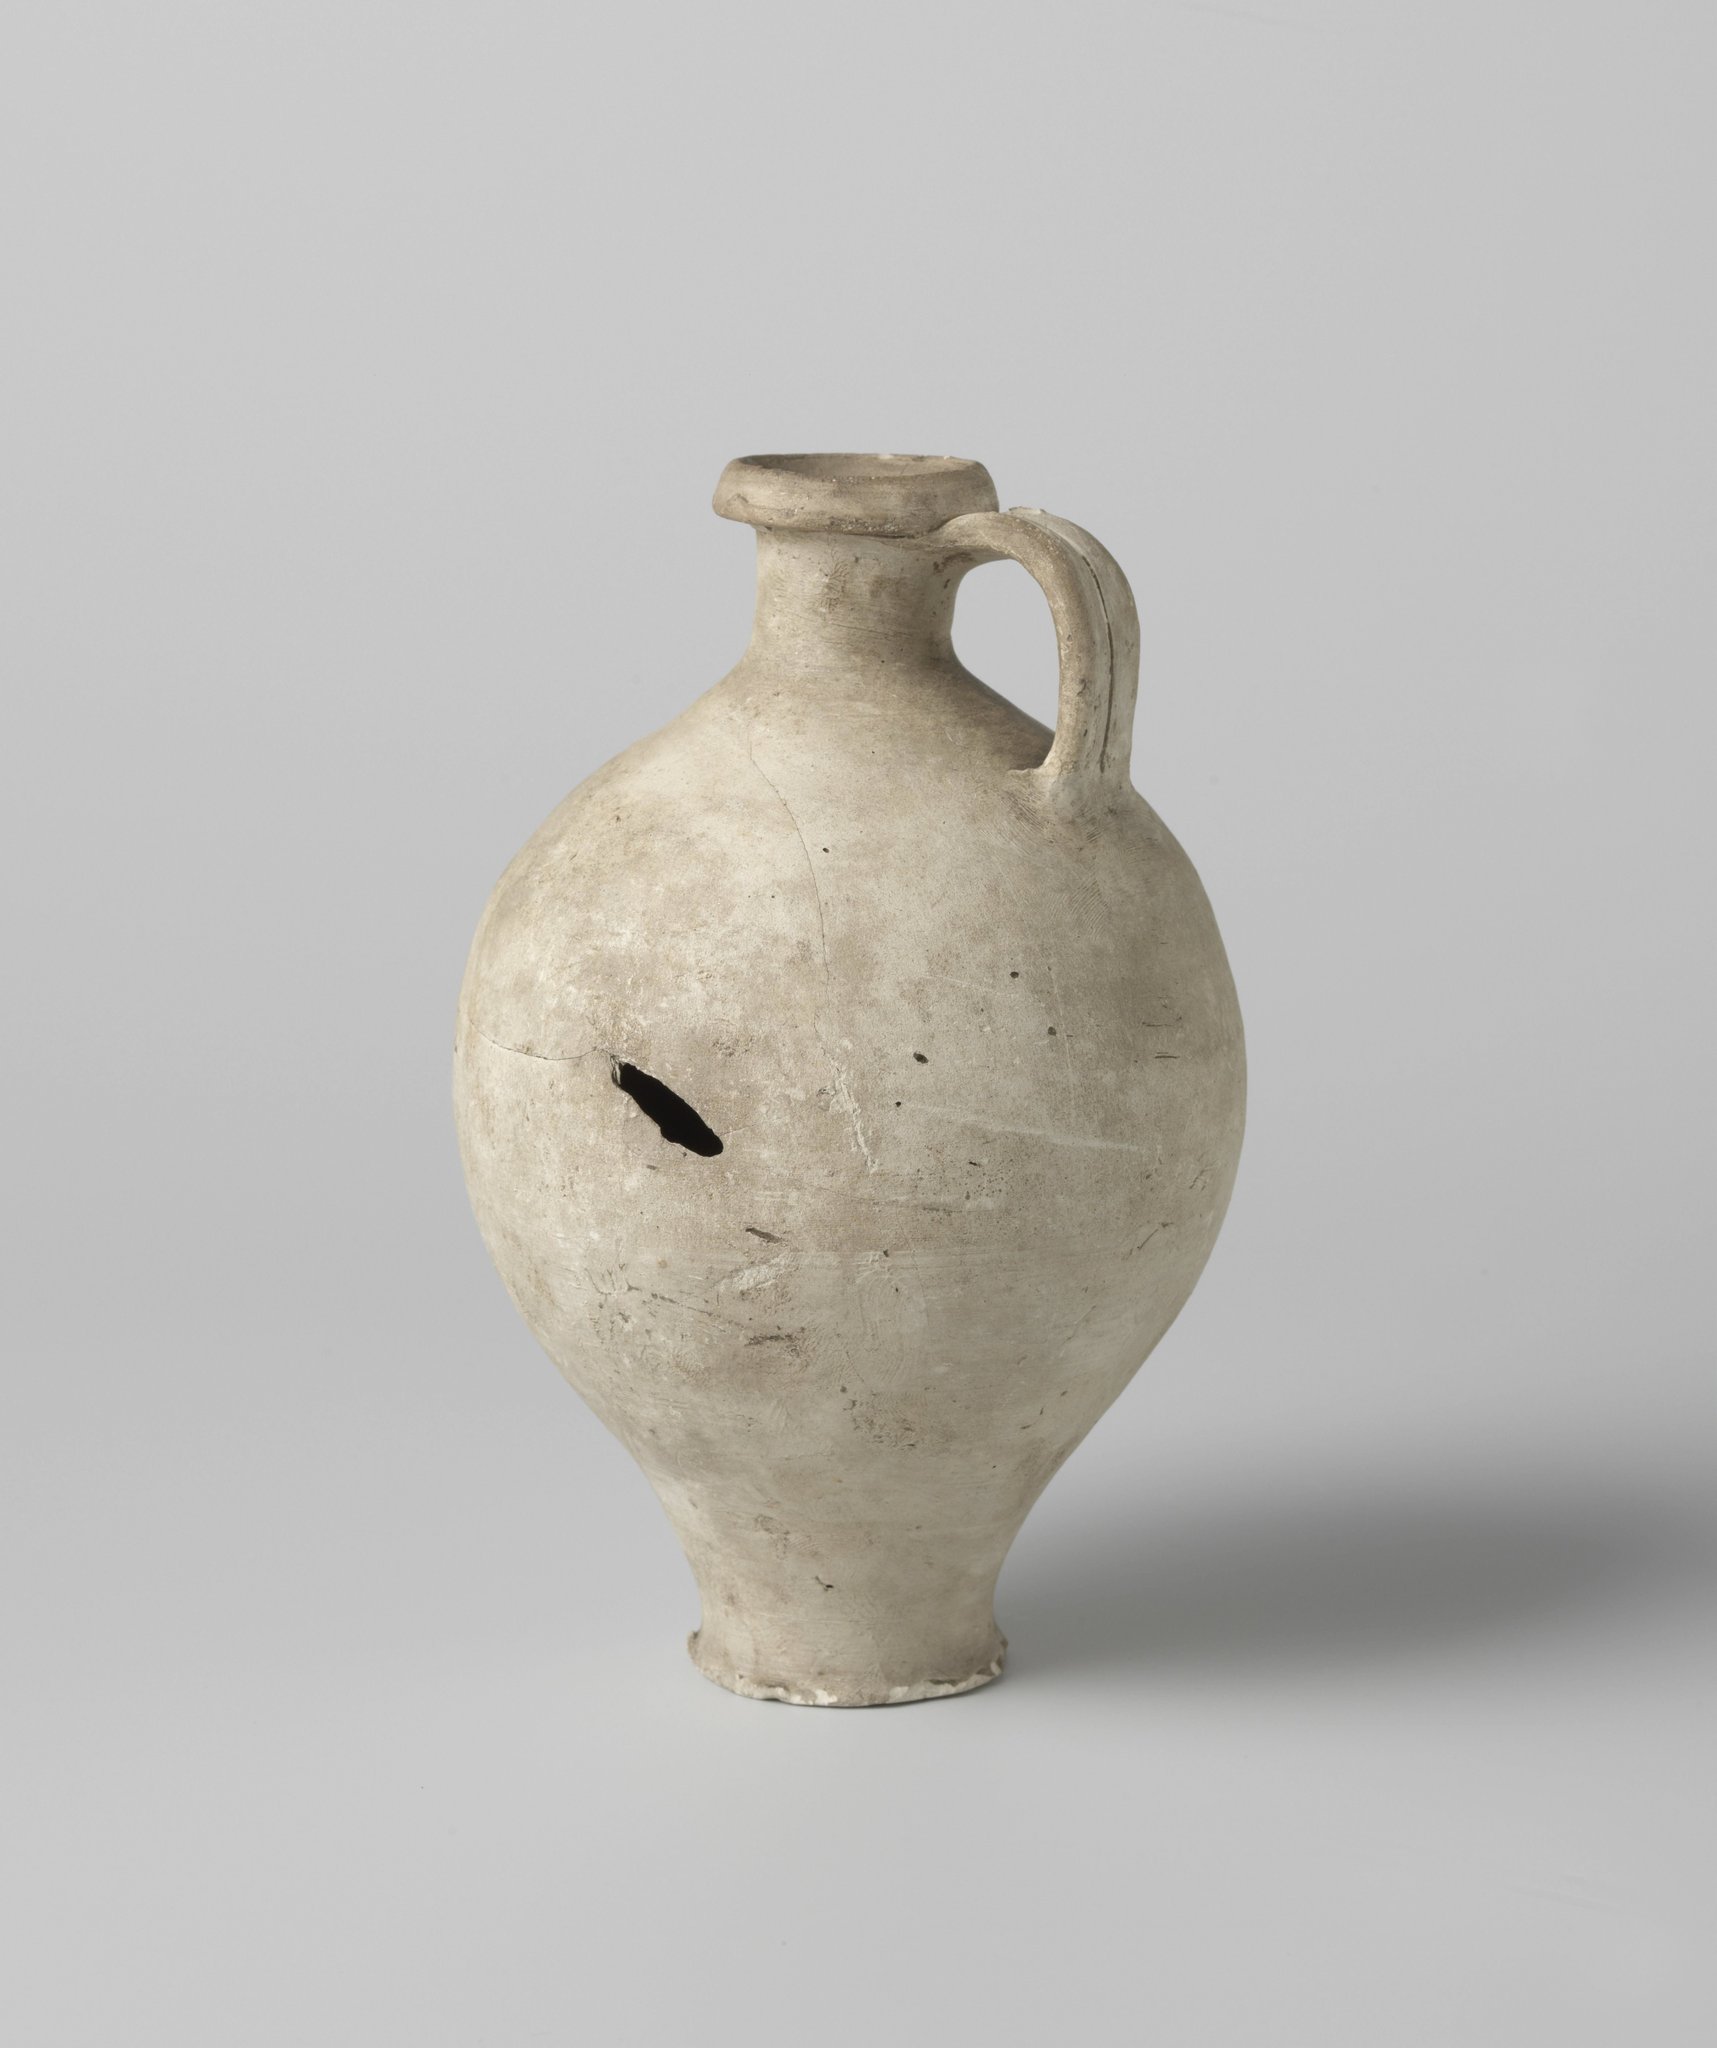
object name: jug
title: Kruik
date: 100-200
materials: earthenware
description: Kruik van crèmekleurig/grijs aardewerk. De omgekeerd peervormige buik wordt aan de bovenzijde bekroond met een lage hals overgaand in een iets bredere, hoekige schenkmond. Het platte oor is versierd met ingekerfde groeven en verbindt de hals via een ronde hoek met de bovenzijde van het lichaam.